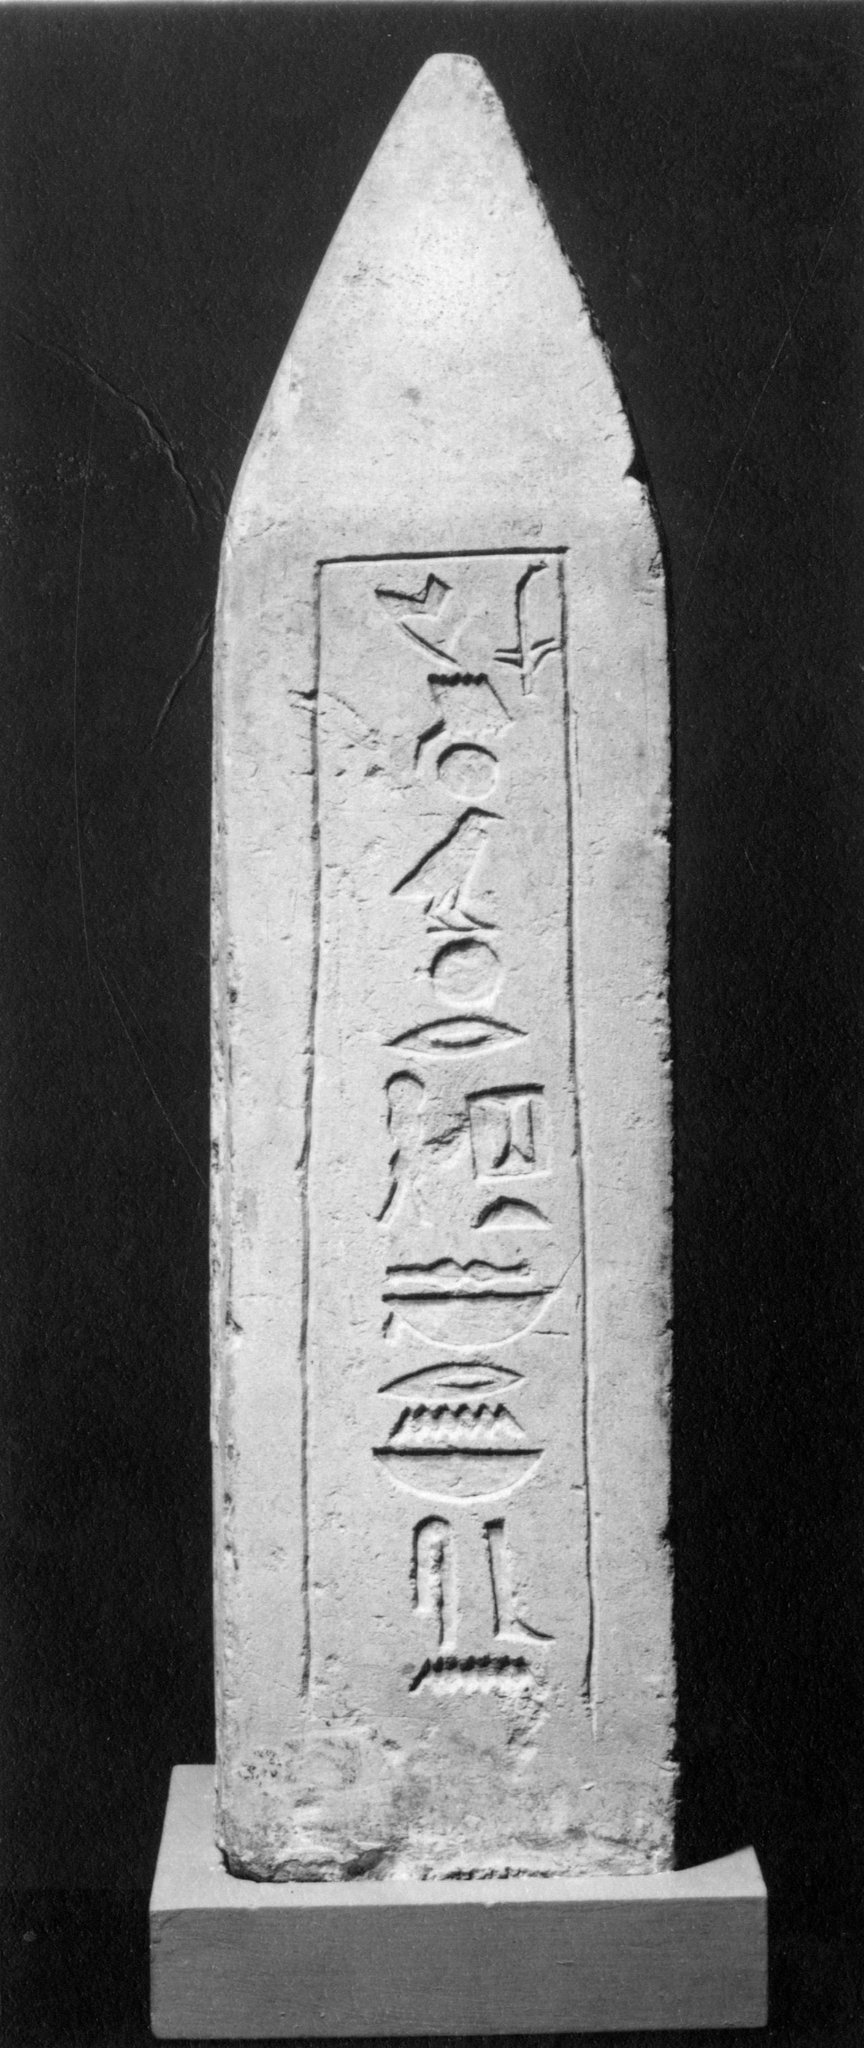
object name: obelisk, nebsen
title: Obelisk of Nebsen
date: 2323-2100 BCE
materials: limestone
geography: egypt